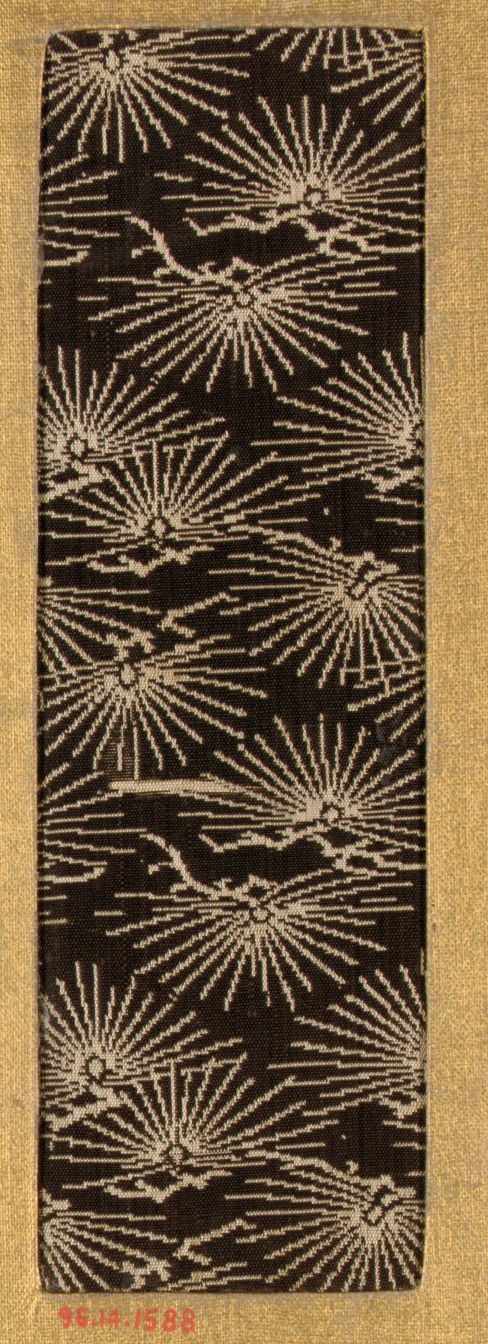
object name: piece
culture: japanese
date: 1701-1900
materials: silk